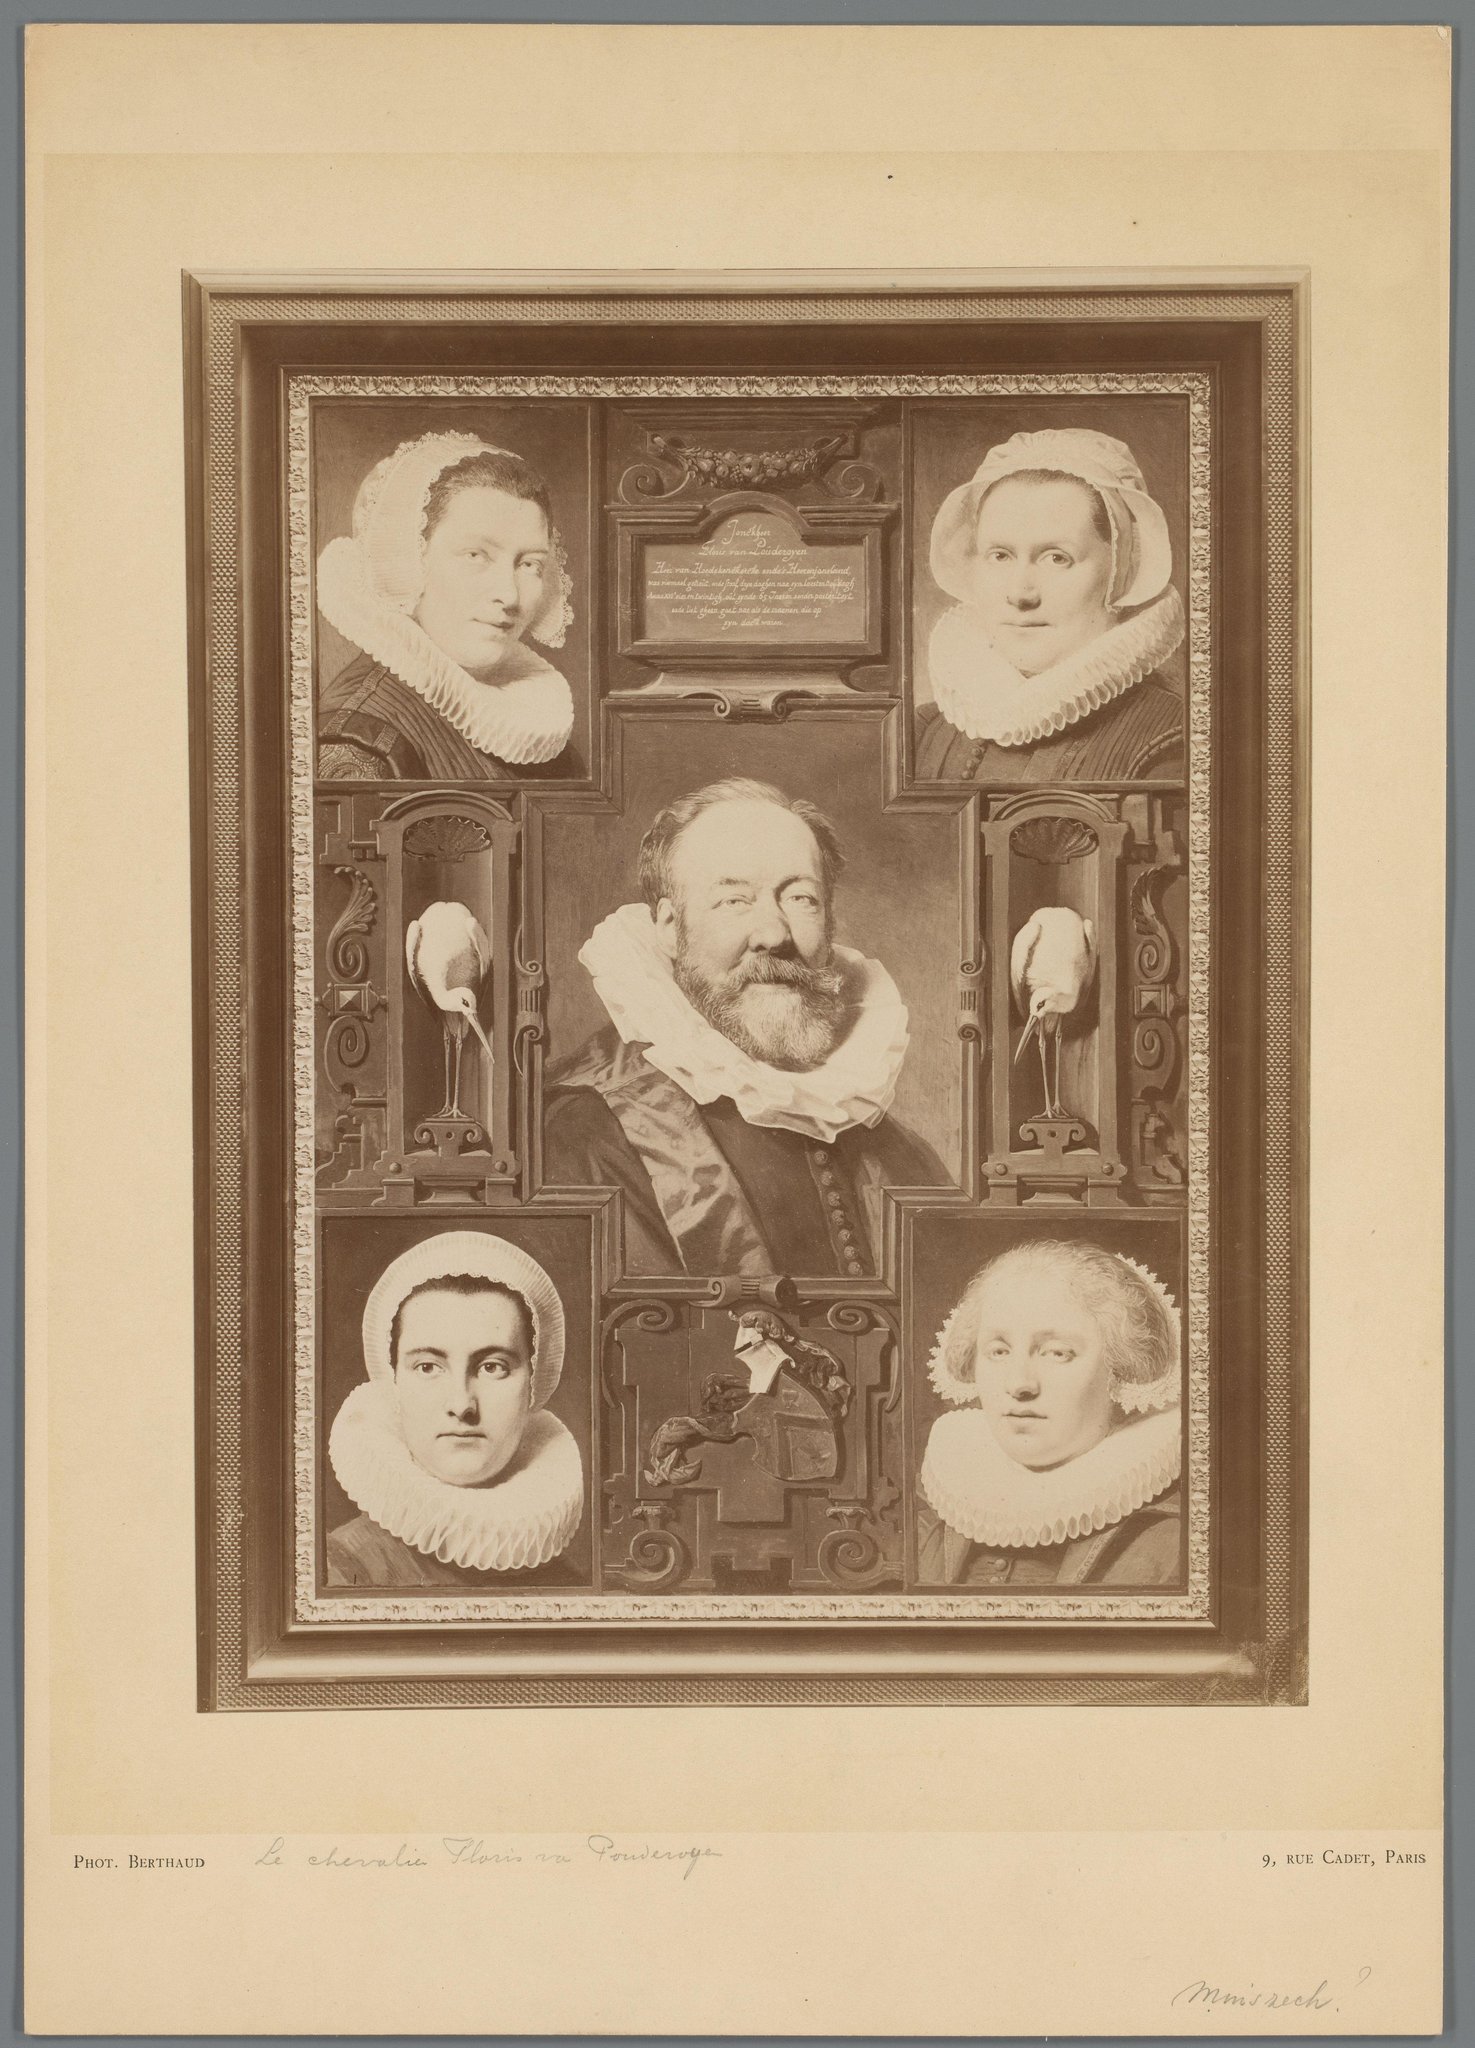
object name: reproduction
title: Le chevalier Flors van Pouderoyen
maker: michel berthaud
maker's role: publisher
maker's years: 1845-1912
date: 1889-1908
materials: cardboard, paper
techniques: albumen print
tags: historical persons, anonymous historical persons portrayed in a group, in a group-portrait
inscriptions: collector's mark: Lugt 2228, inscription: ‘Mins zech?’